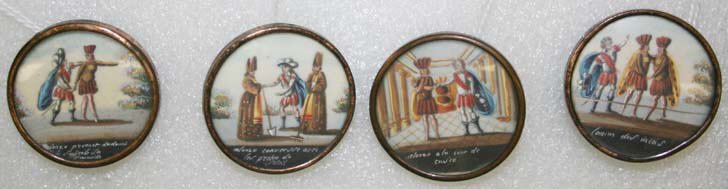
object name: button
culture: french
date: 1770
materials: glass, ivory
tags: men